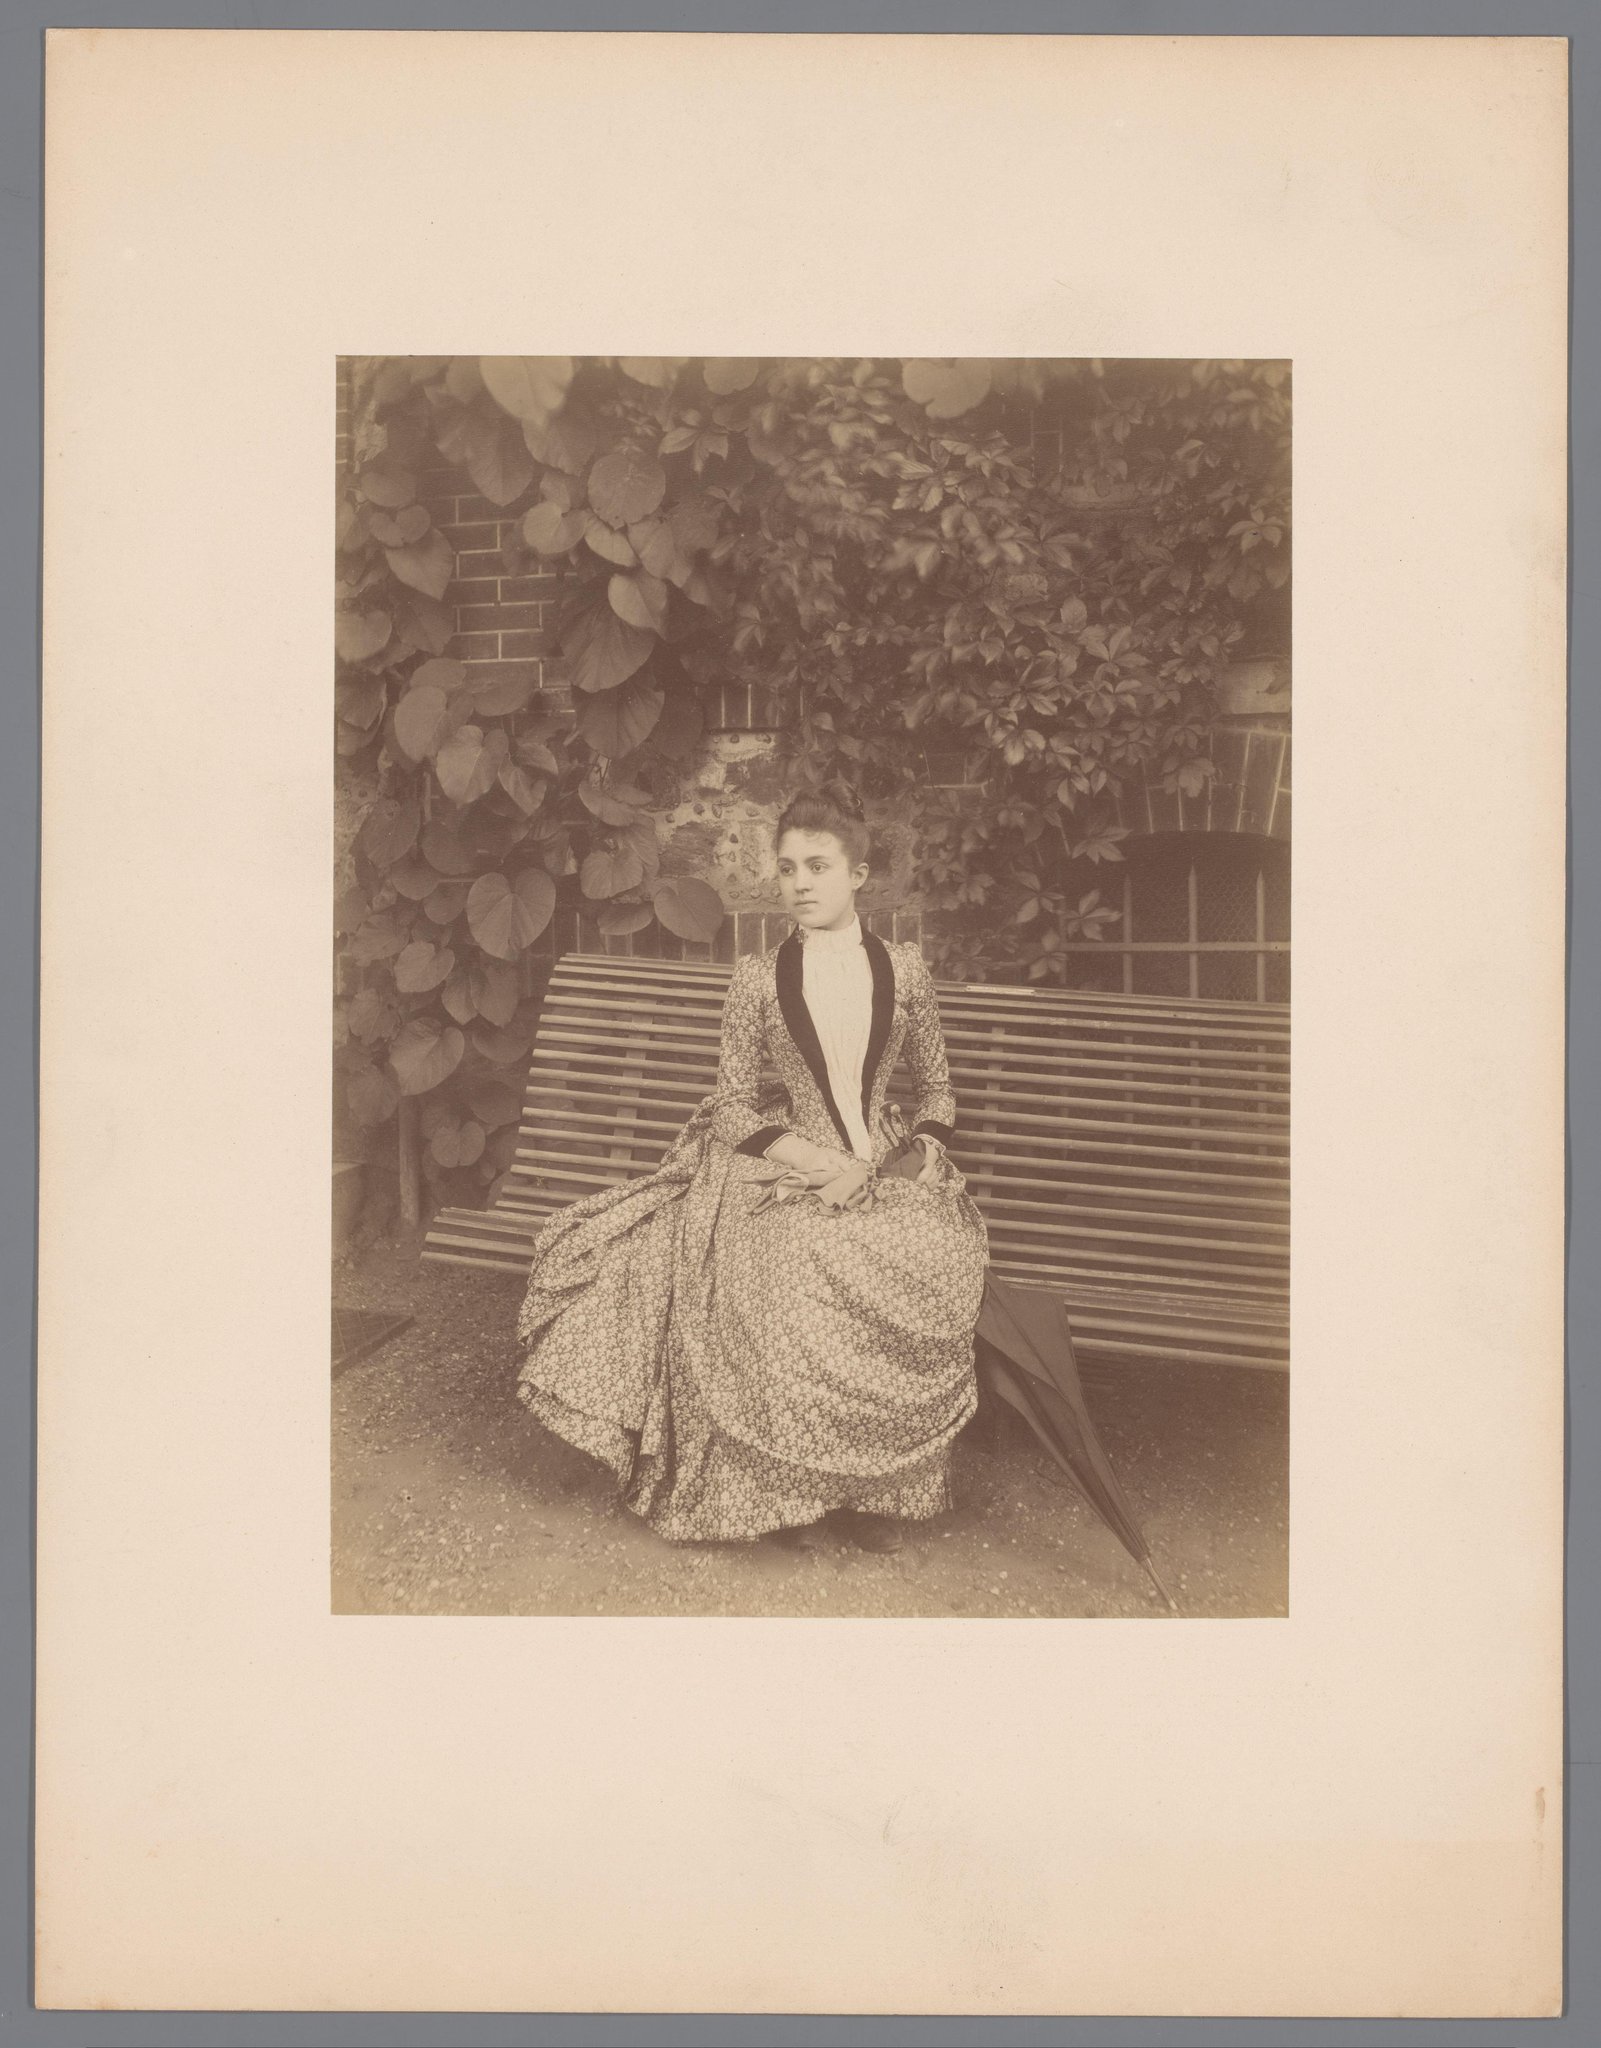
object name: photograph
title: Portret van zittende jonge vrouw in tuin of park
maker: Anonymous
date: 1890-1900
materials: cardboard, paper, photographic support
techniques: albumen print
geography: france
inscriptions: annotation: ‘1890's’, annotation: ‘1552’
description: Portret van zittende jonge vrouw op een bankje in een tuin of park. Vrouw heeft een deftige jurk aan en een paraplu naast zich en kijkt naar links langs de camera. Zelfde tuin als RP-F-00-6050 n RP-F-00-6051.